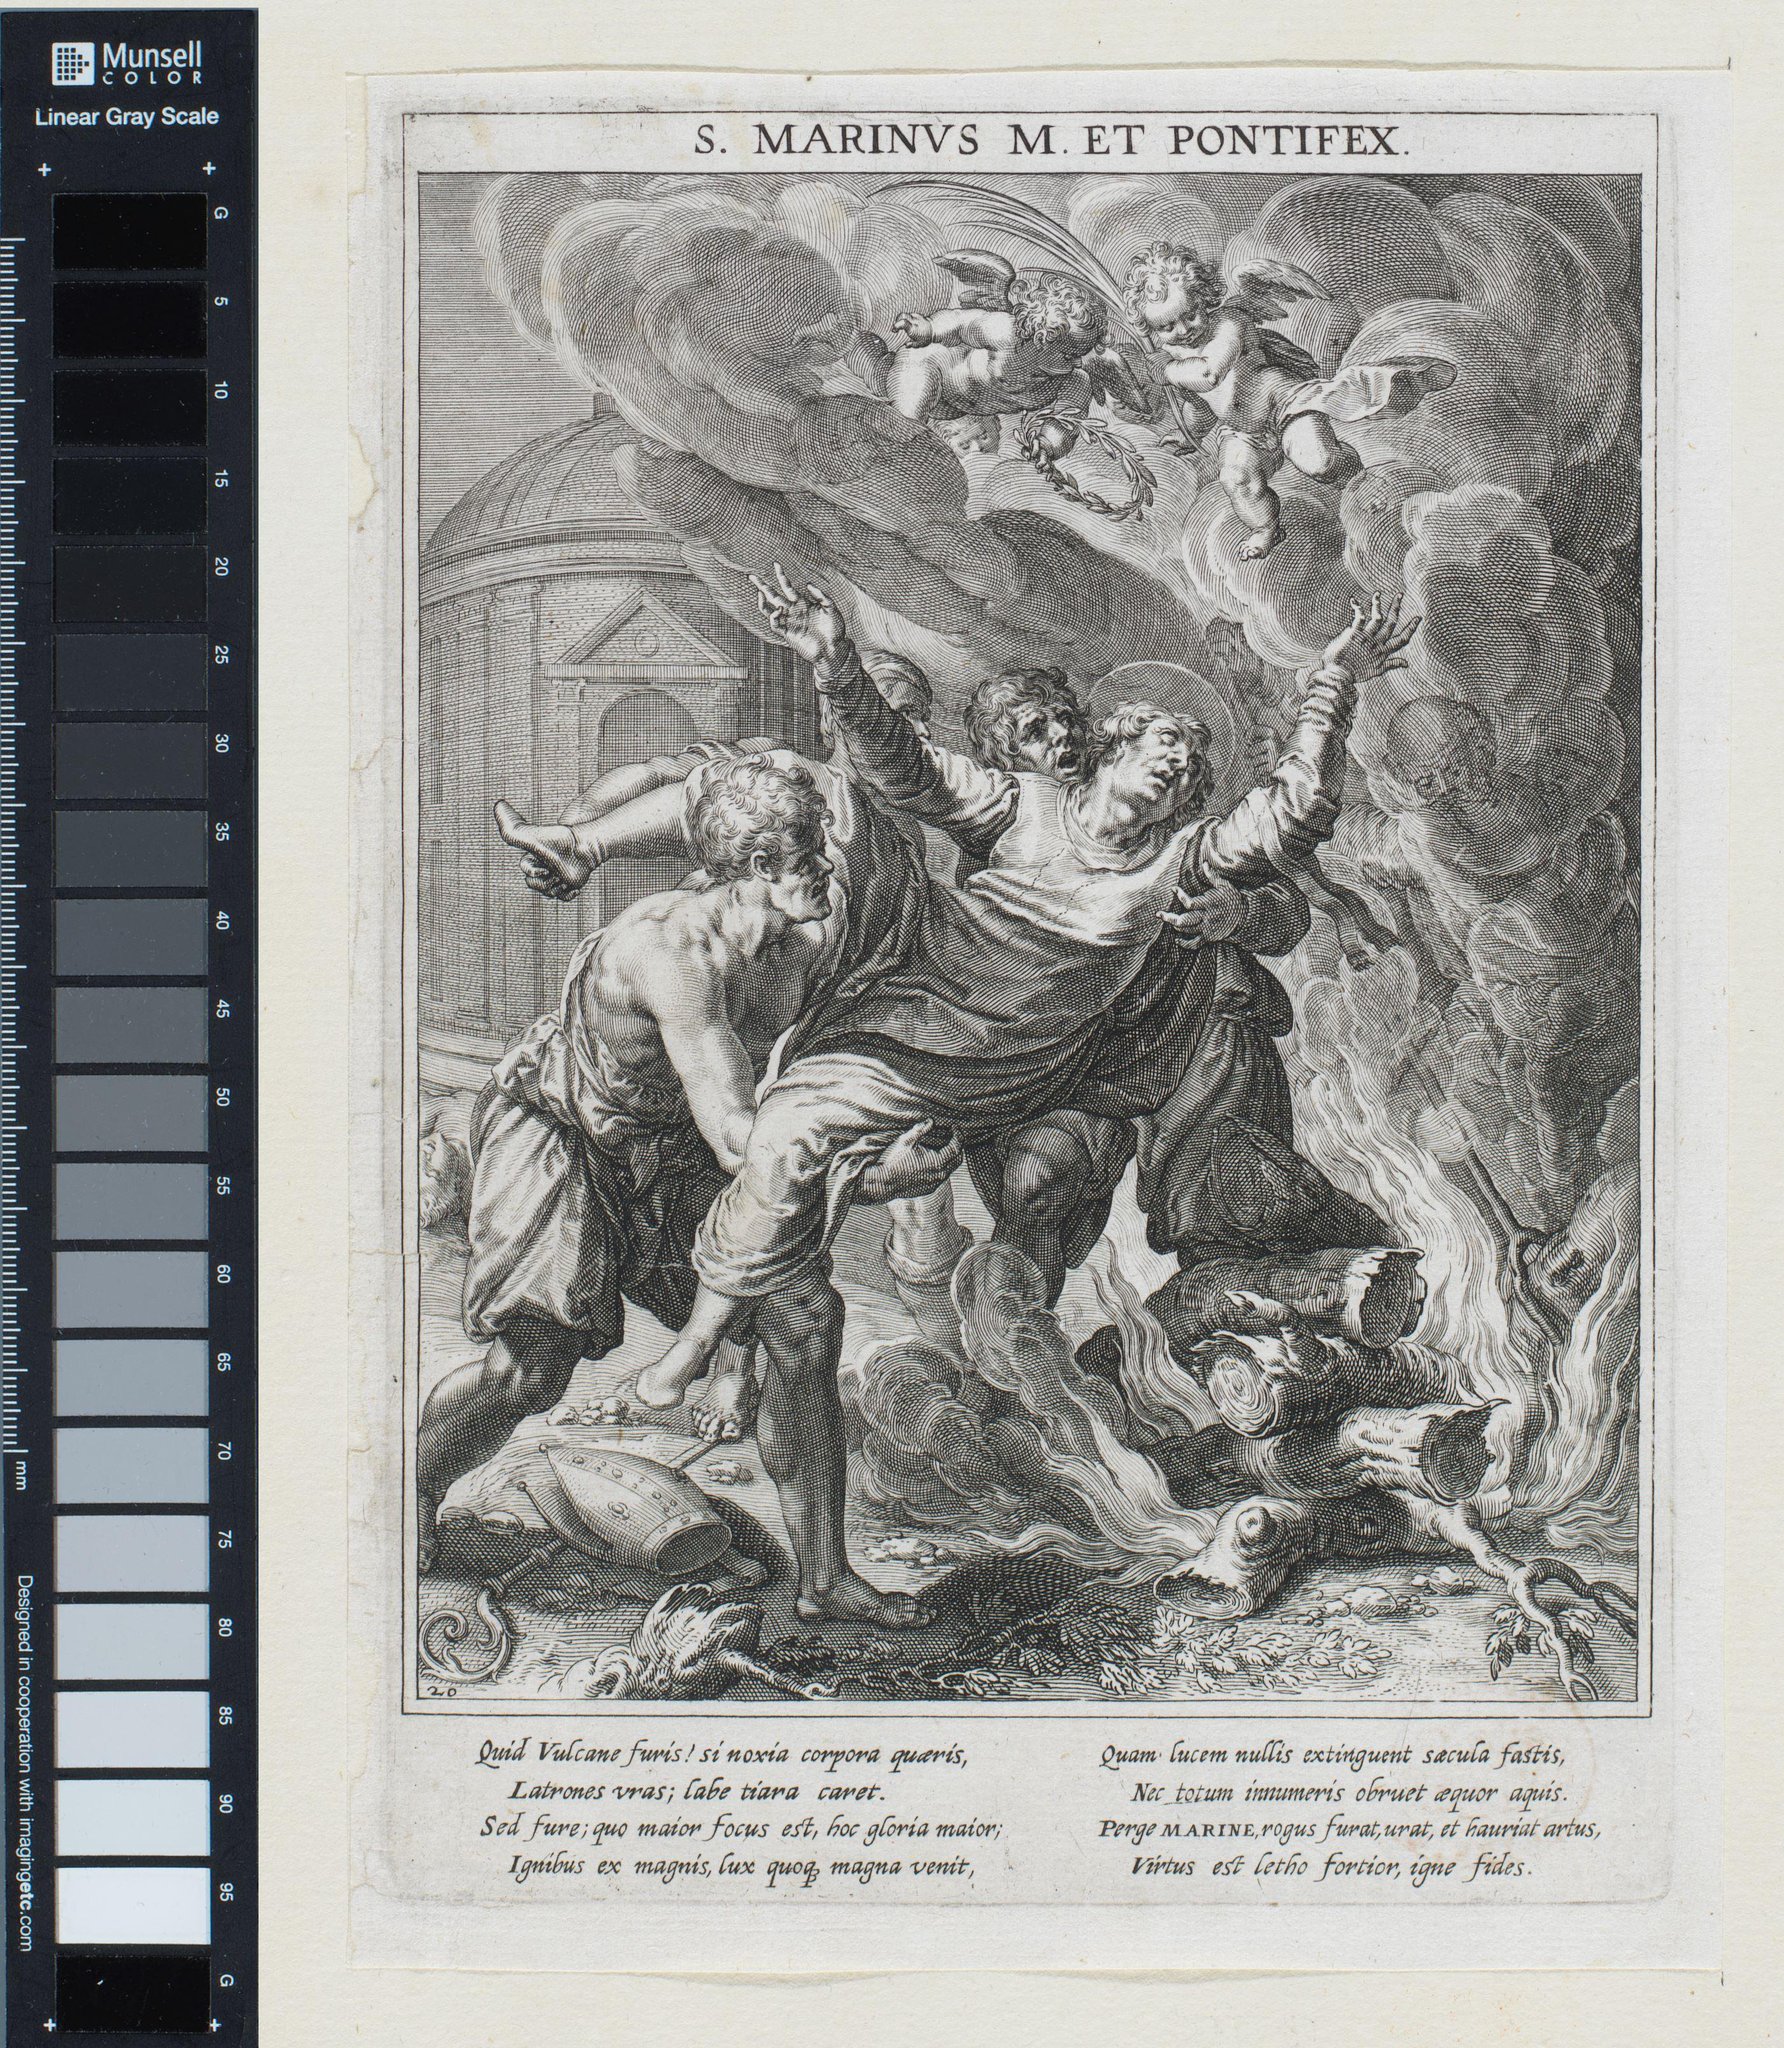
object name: print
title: Marteldood van de heilige Marianus op een brandstapel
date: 1615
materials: paper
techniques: engraving, etching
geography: munich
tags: male saints (with name), angels crowning and/or bringing palm-branches, violent death ~ fire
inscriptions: collector's mark: Lugt 240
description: De H. Marianus van Beieren wordt door drie soldaten van de stam der Vandalen op een brandstapel gegooid. Twee engelen dalen uit de hemel af om zijn ziel op te nemen. De prent heeft een Latijns onderschrift en is de twintigste prent van een 60-delige serie met als onderwerp de heiligen van Beieren.